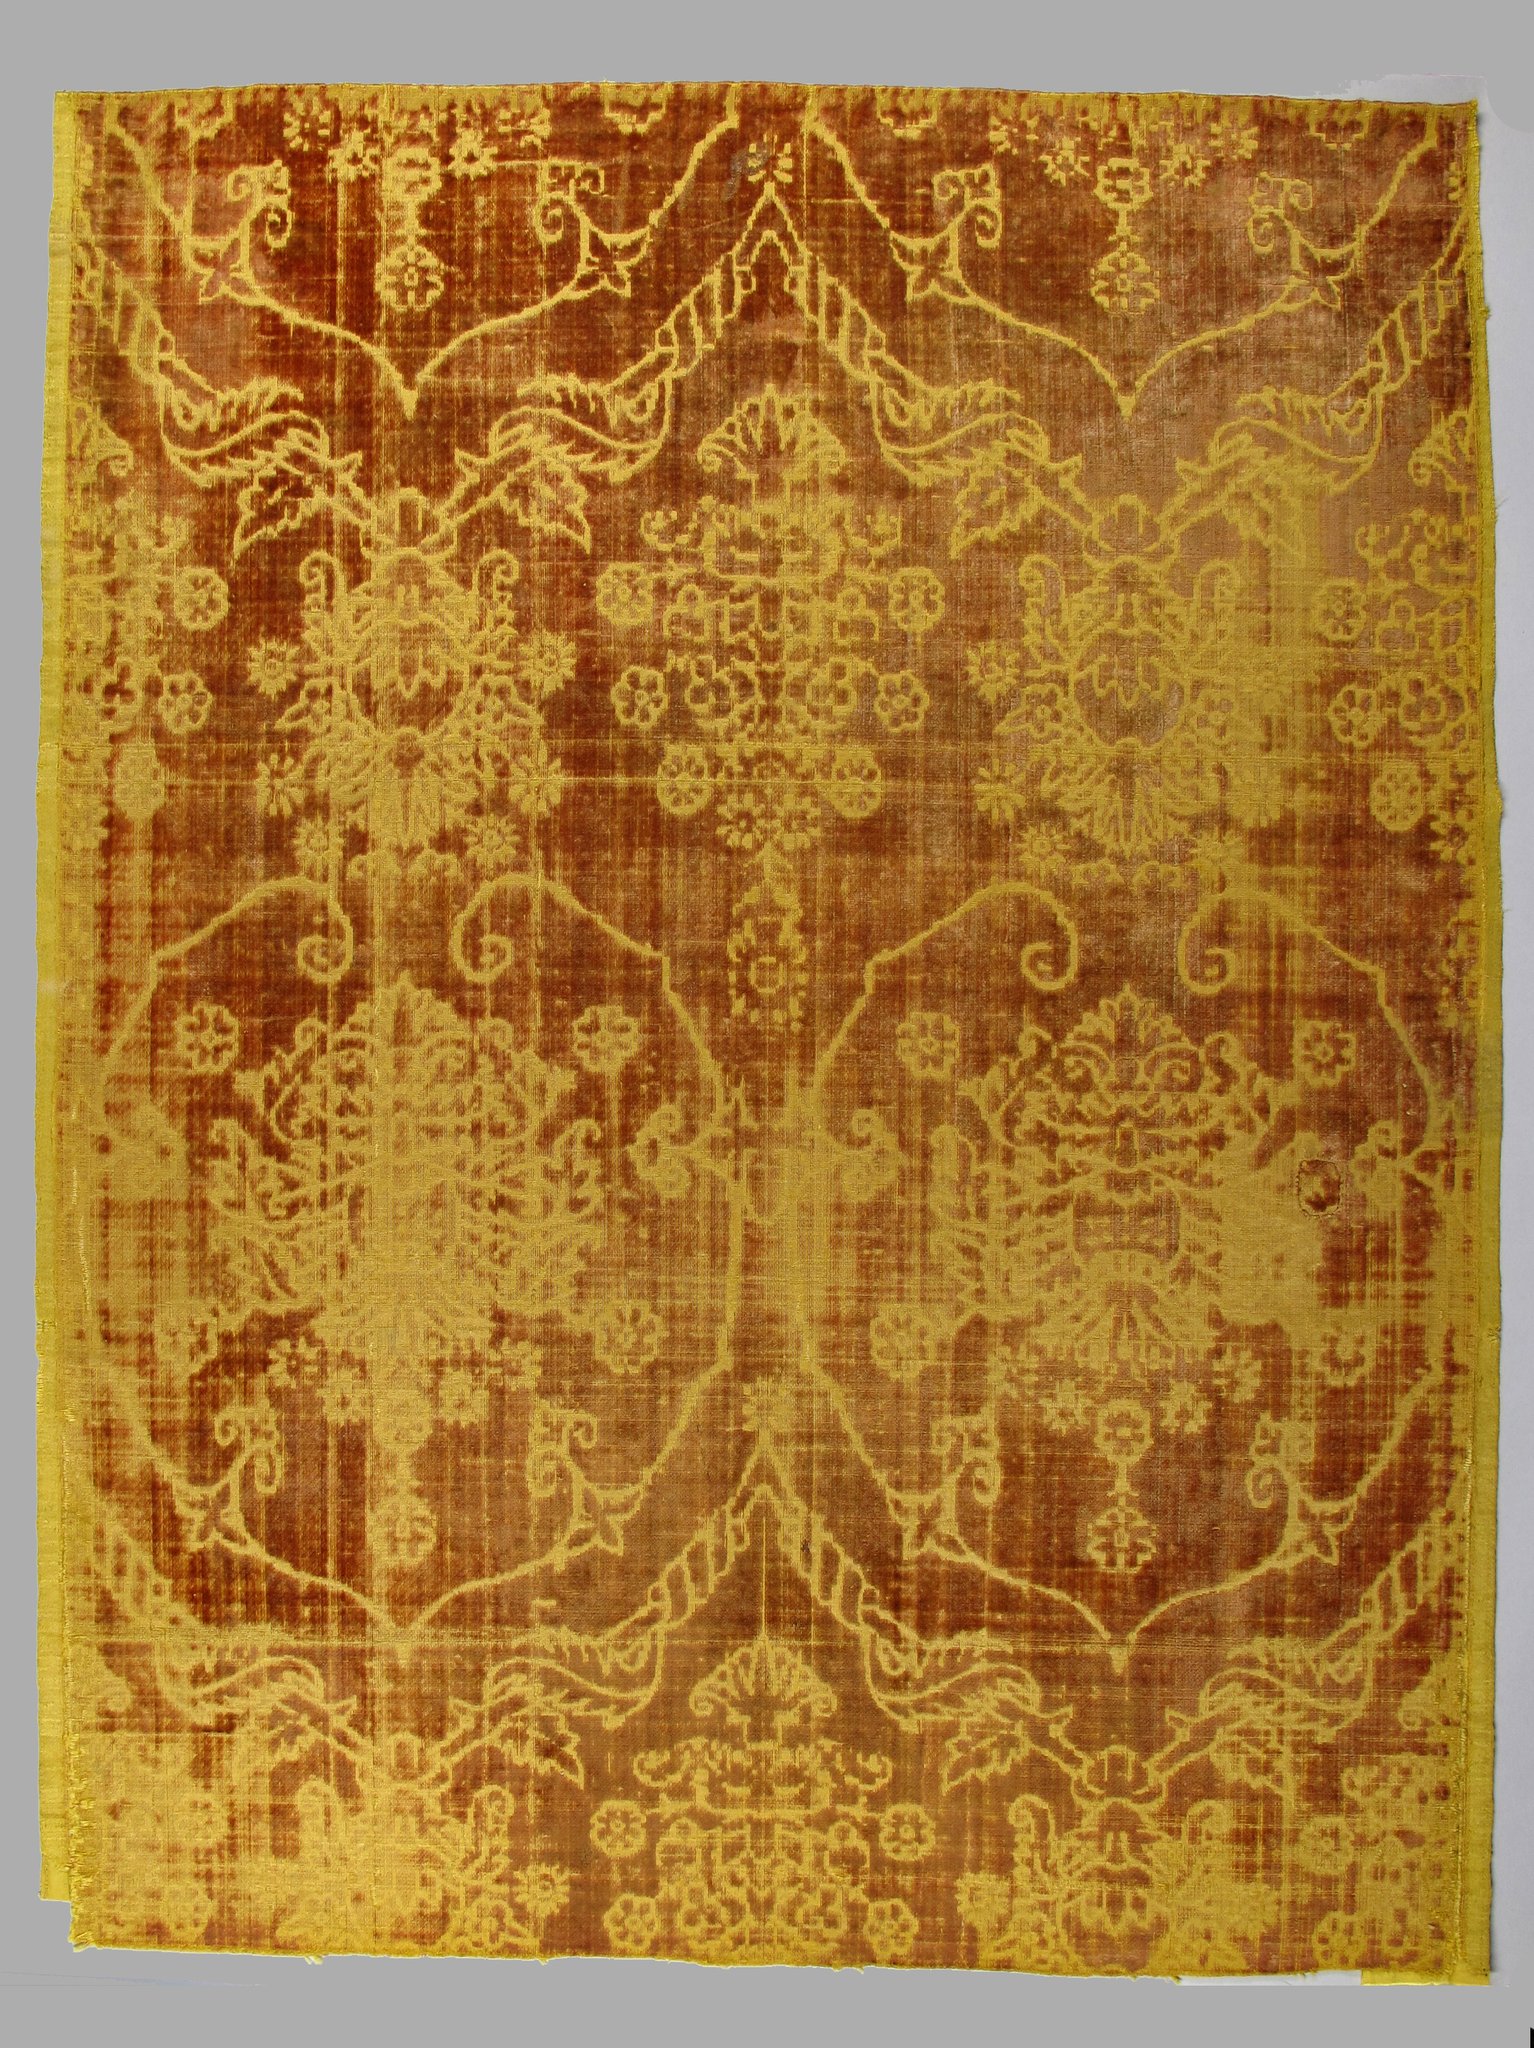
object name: panel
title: Panel of Velvet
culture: italian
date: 1401-1500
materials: velvet